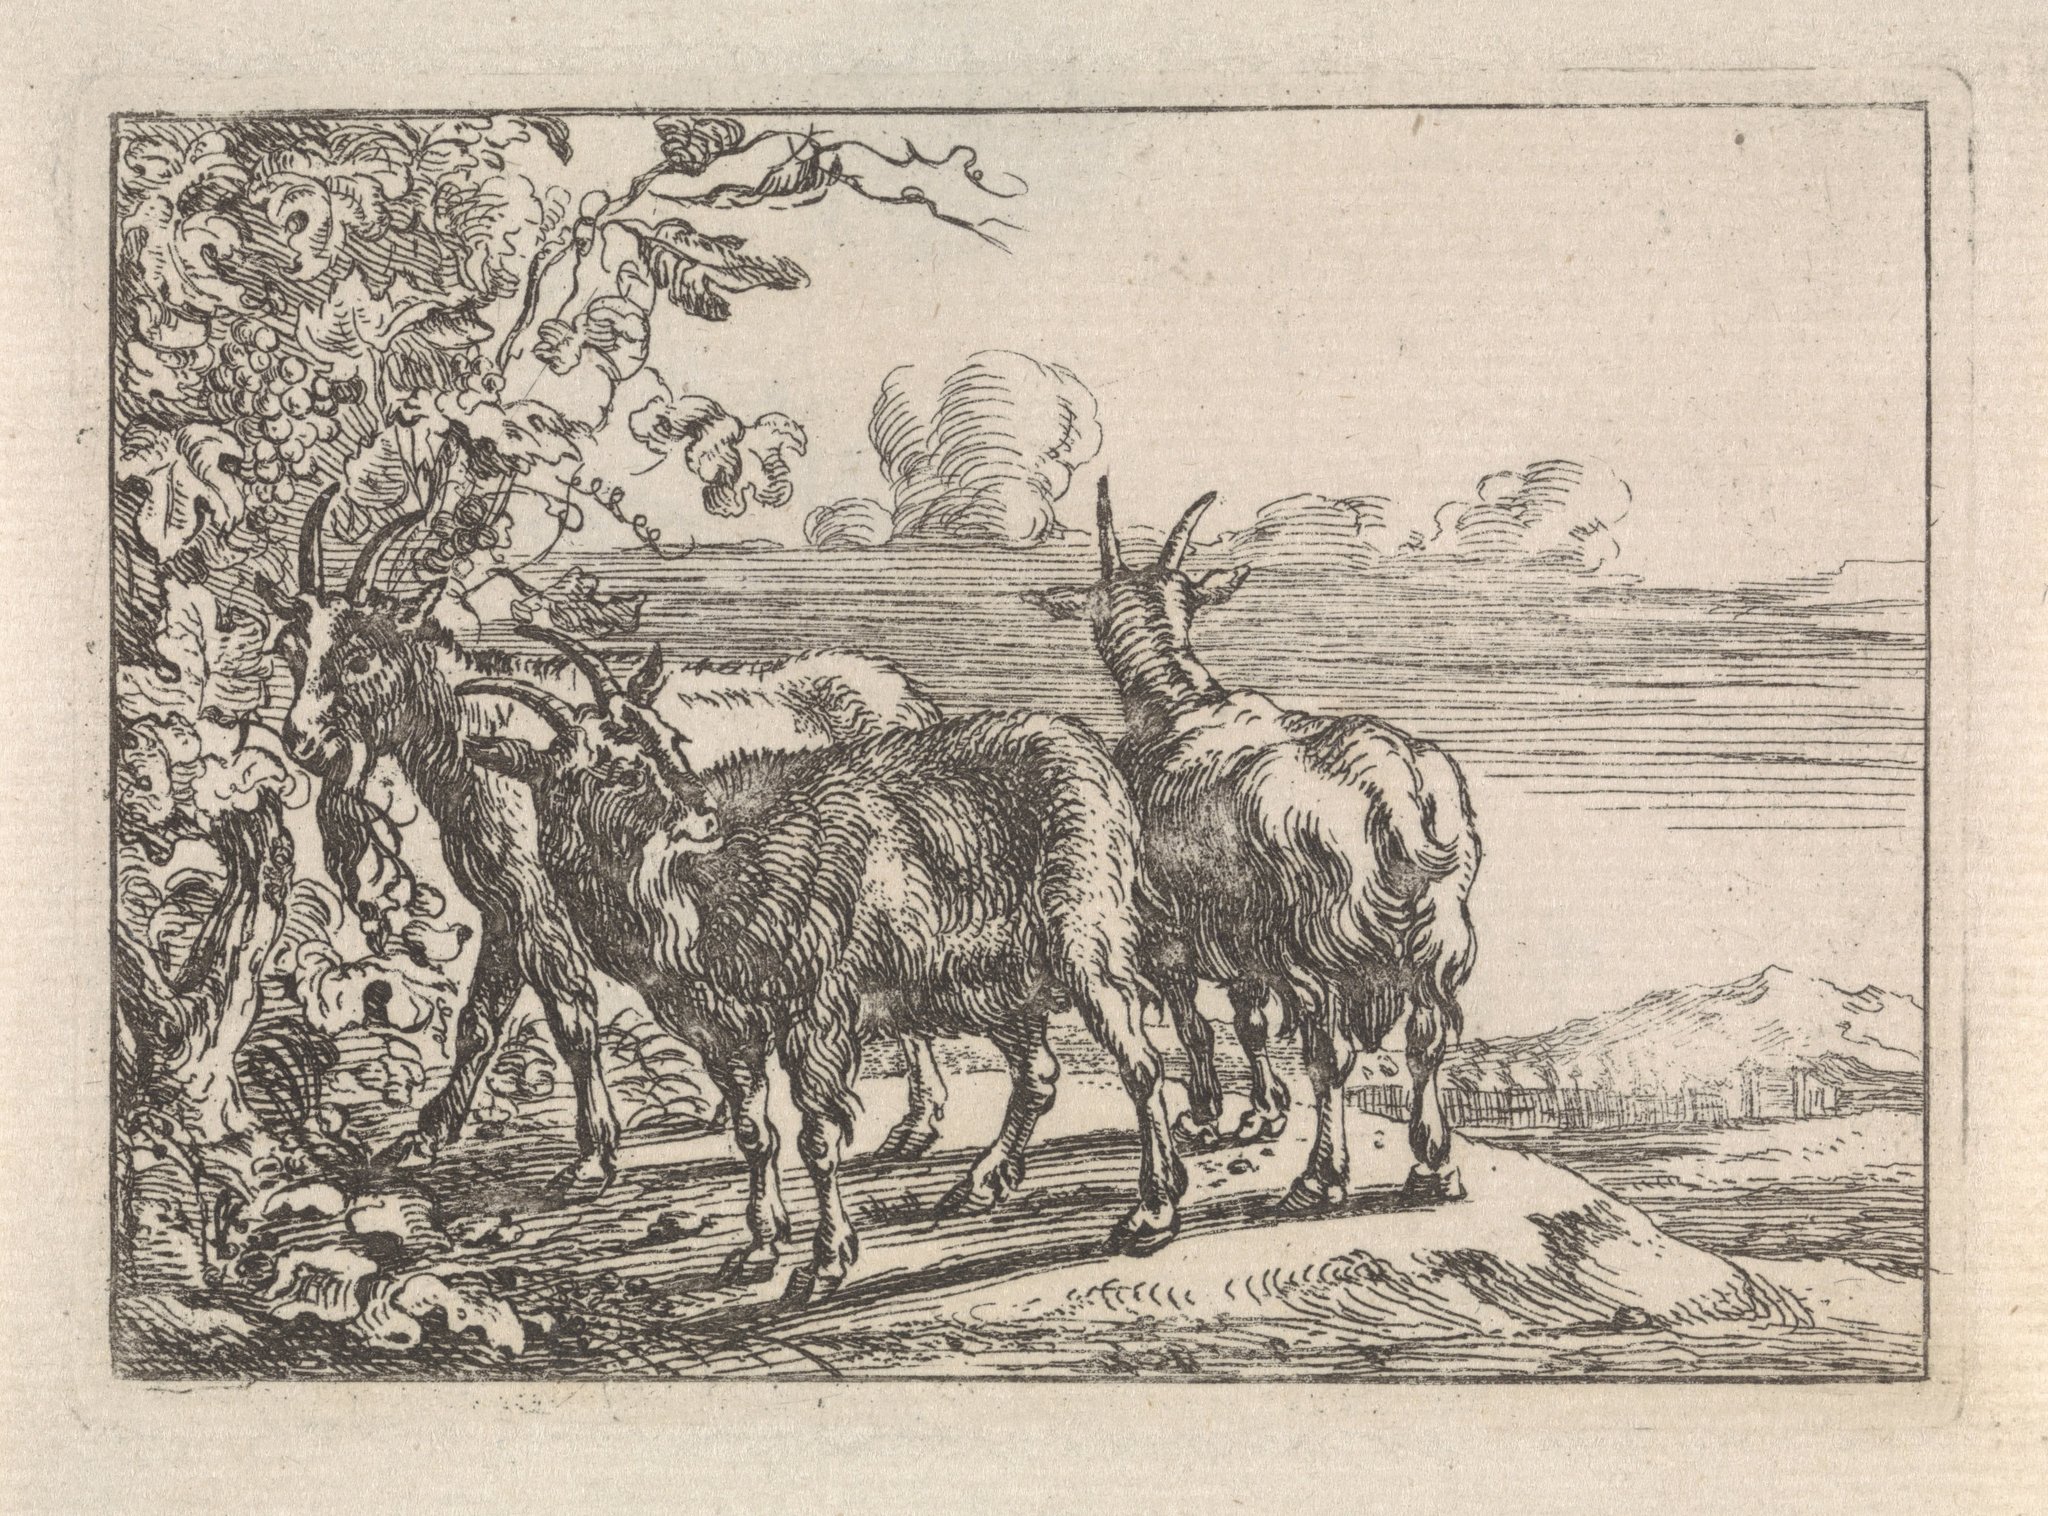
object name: print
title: Geiten bij een wijnrank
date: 1654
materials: paper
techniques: etching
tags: vine-tendril, leaf, landscapes, goat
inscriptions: collector's mark: Lugt 2228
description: In een heuvelachtig landschap staan drie geiten bij een wijnrank die zich om het struikgewas heeft geslingerd. Een van de geiten is van achter gezien. Deze prent maakt deel uit van een tiendelige serie over diverse dieren.